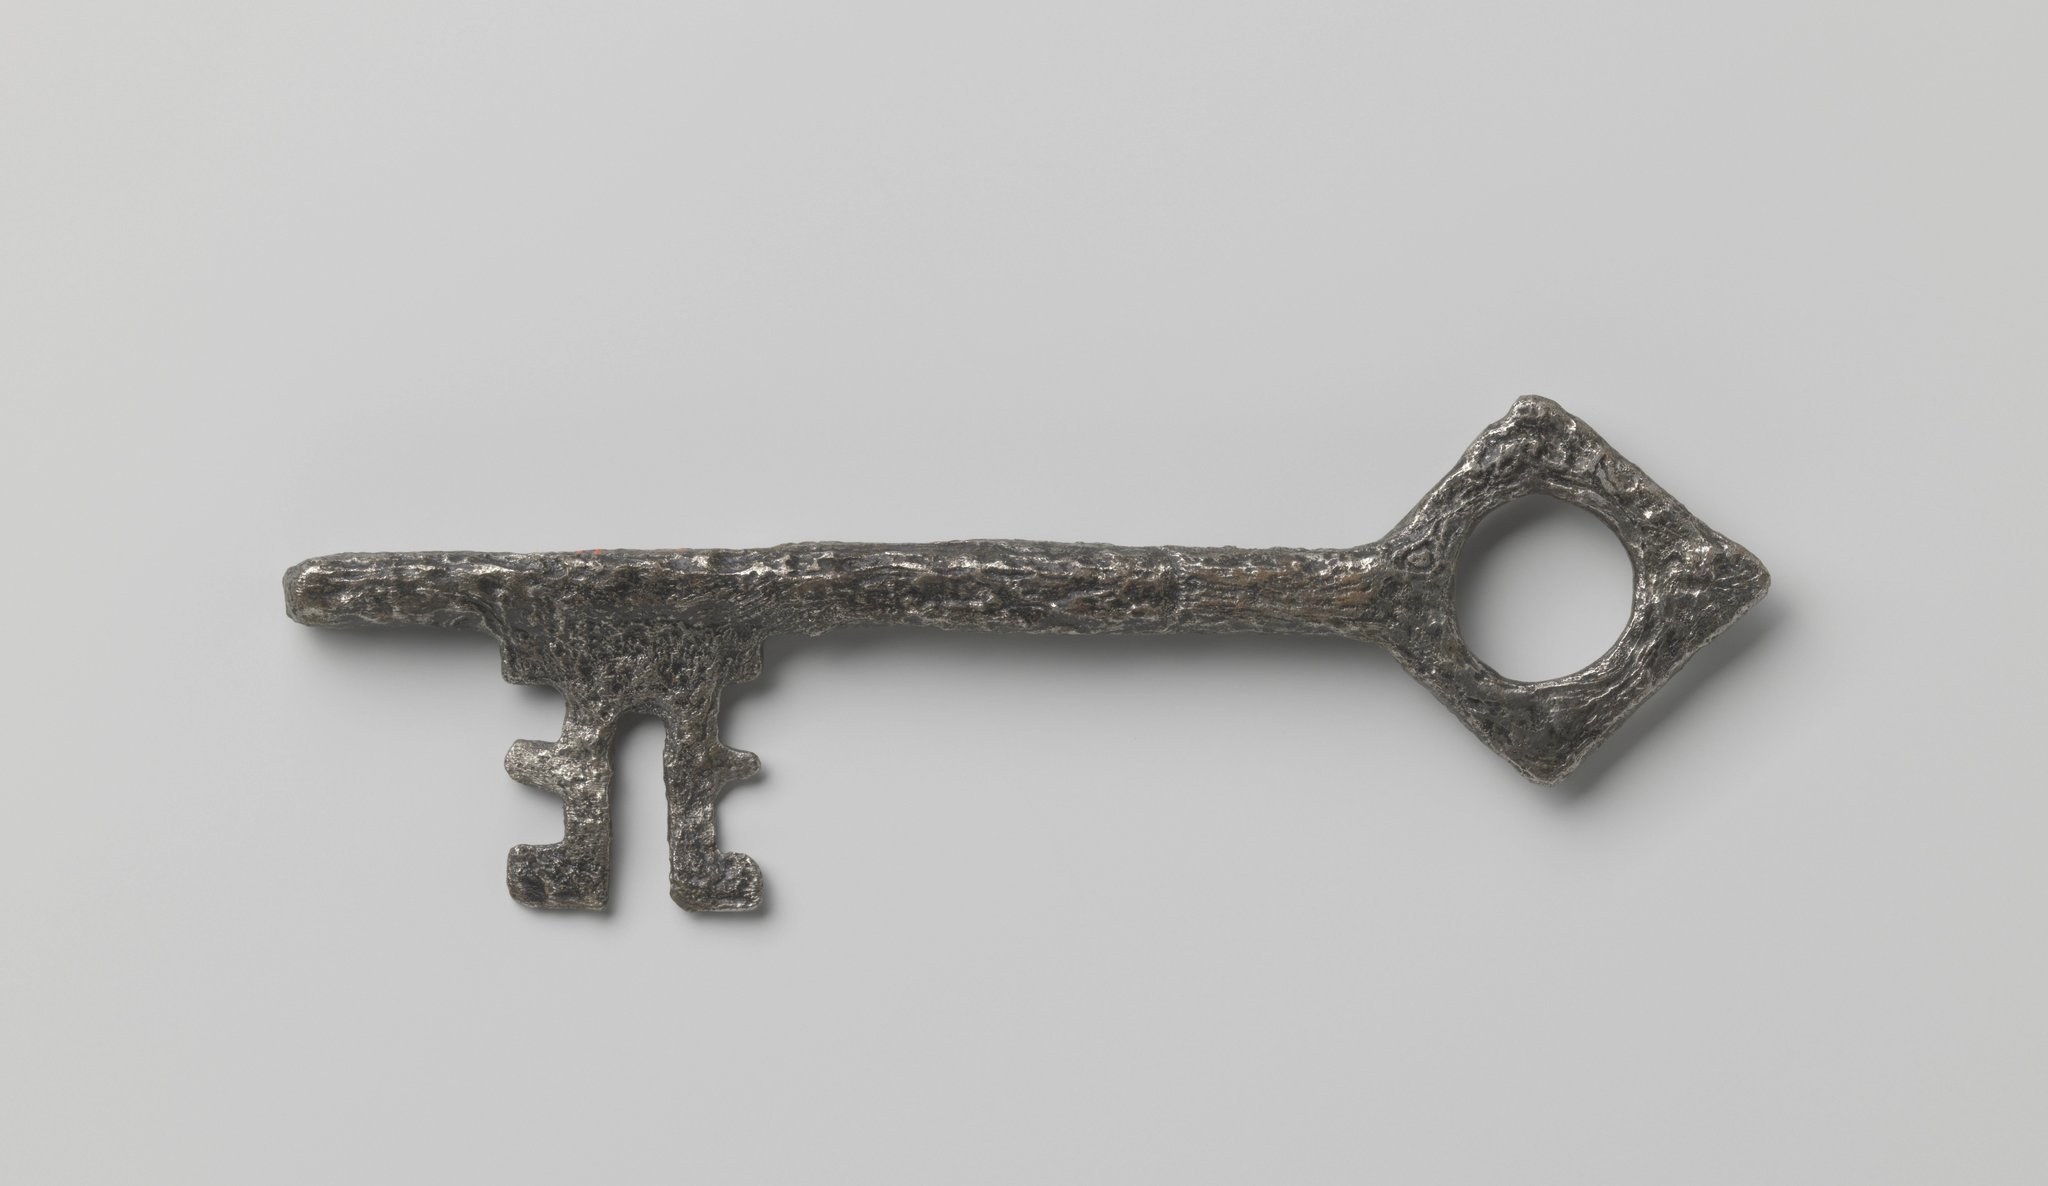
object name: key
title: Sleutel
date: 1300-1400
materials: iron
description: Sleutel met een ruitvormige greep, voorzien van een gat en een voorbij de baard doorlopende schacht.